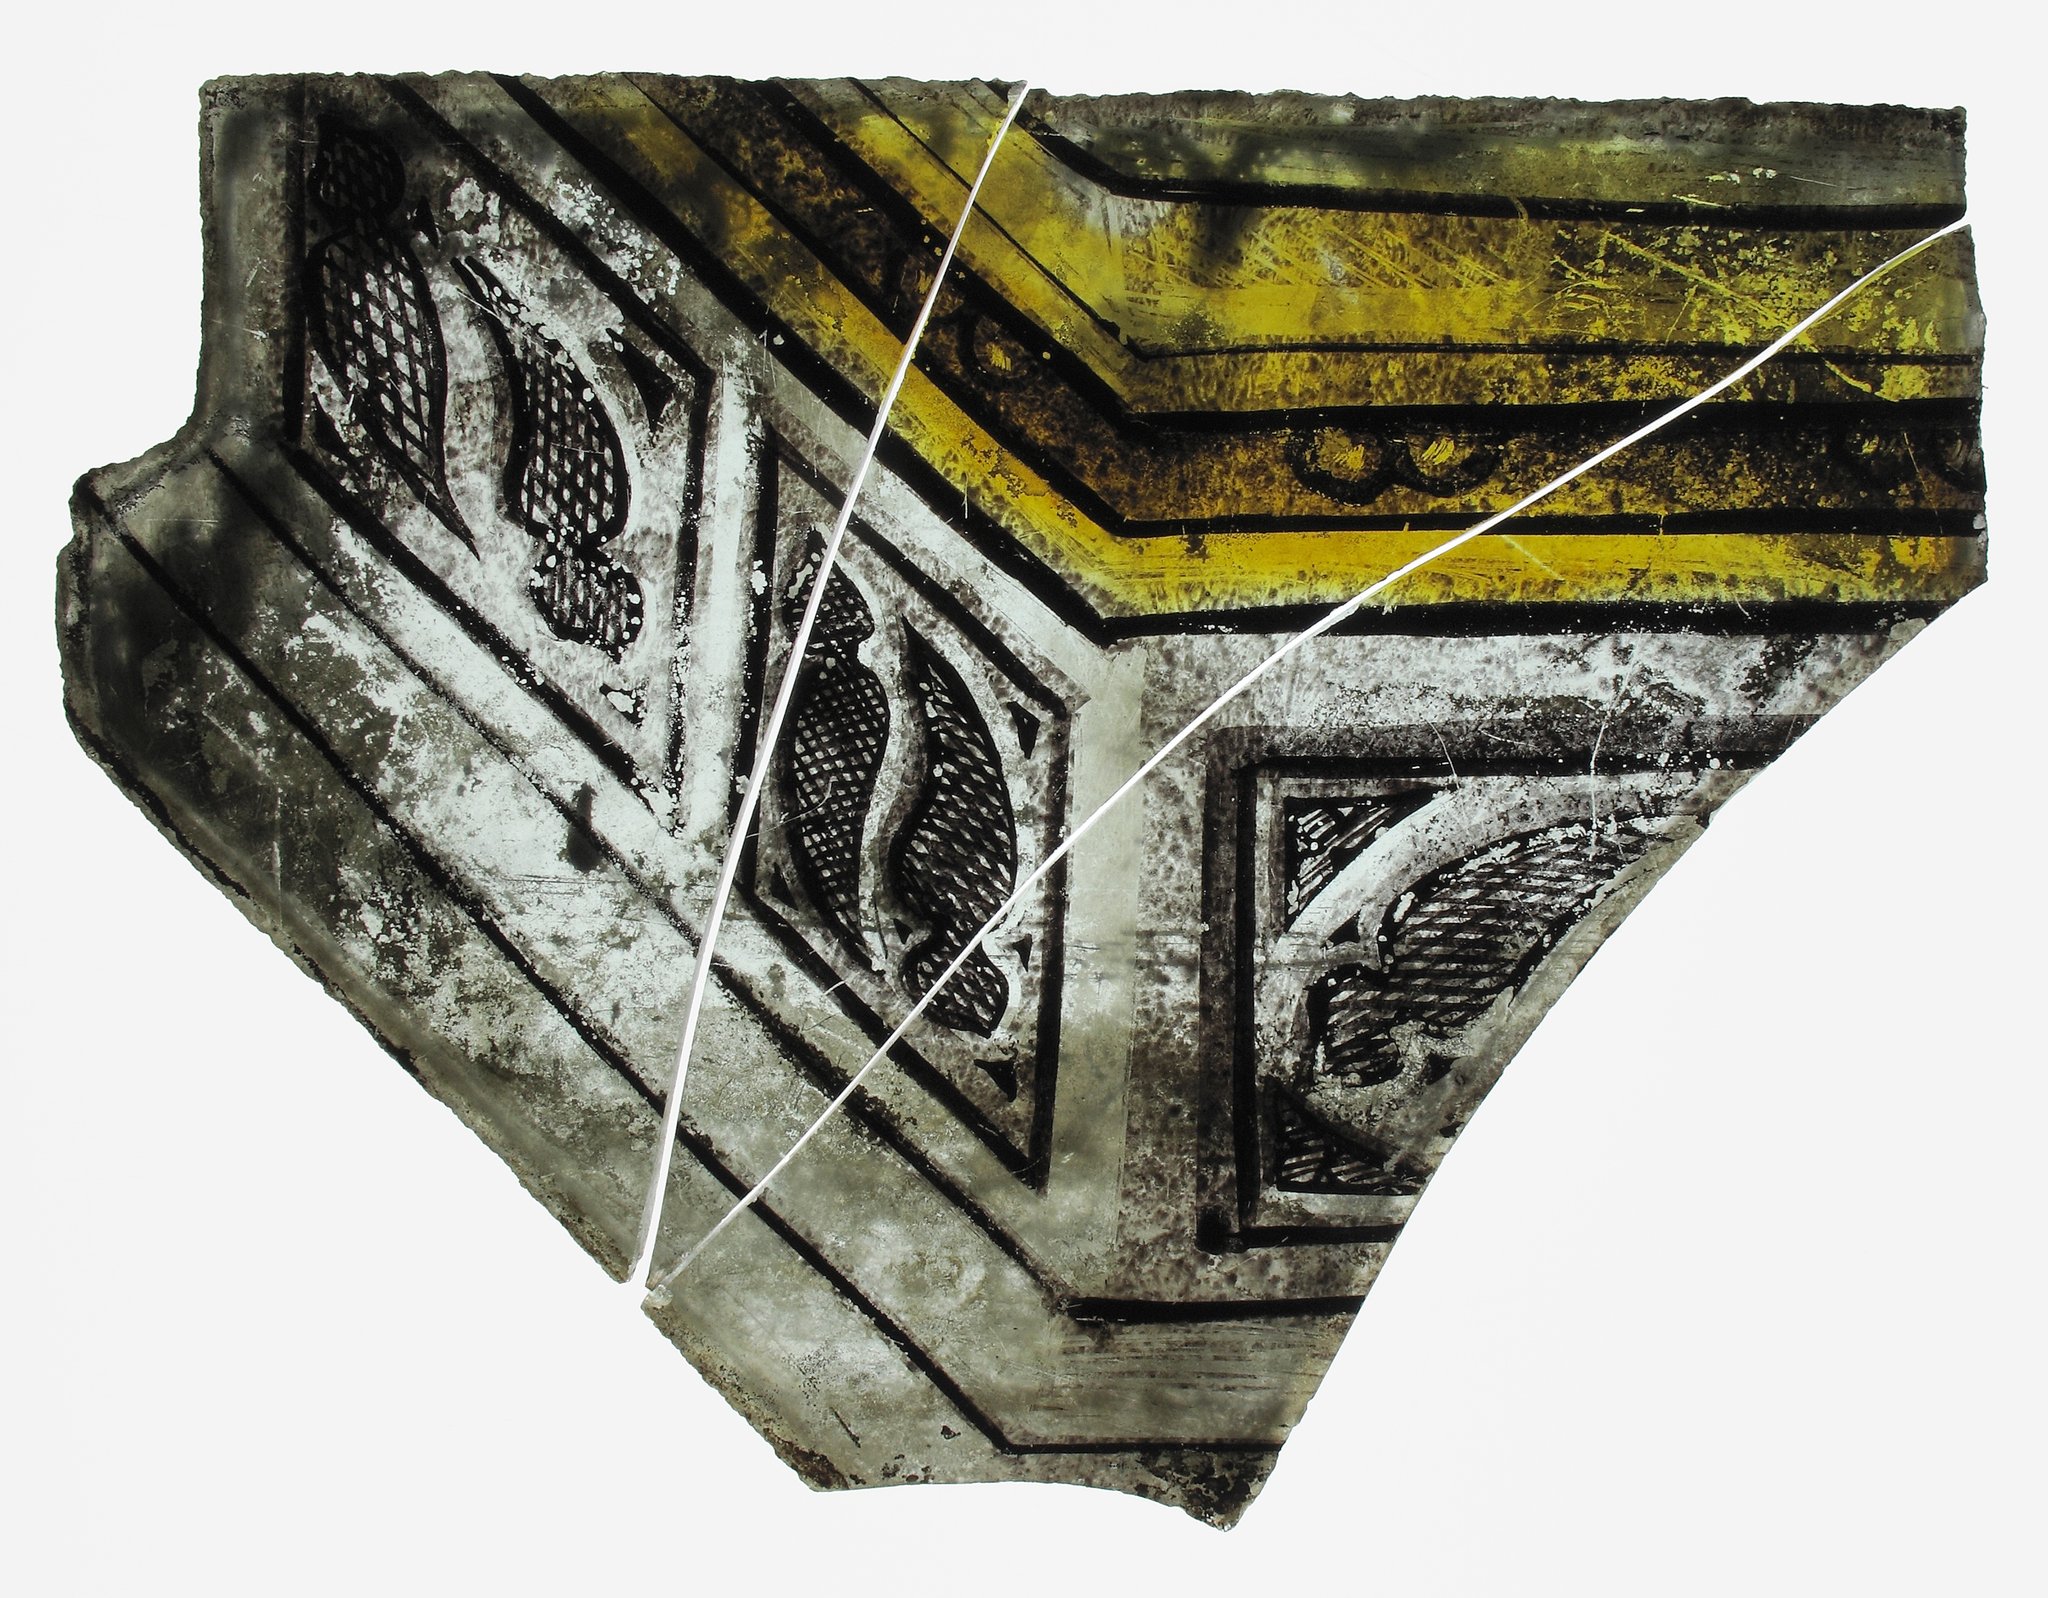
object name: fragment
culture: european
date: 1101-1700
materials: glass, metal, paint